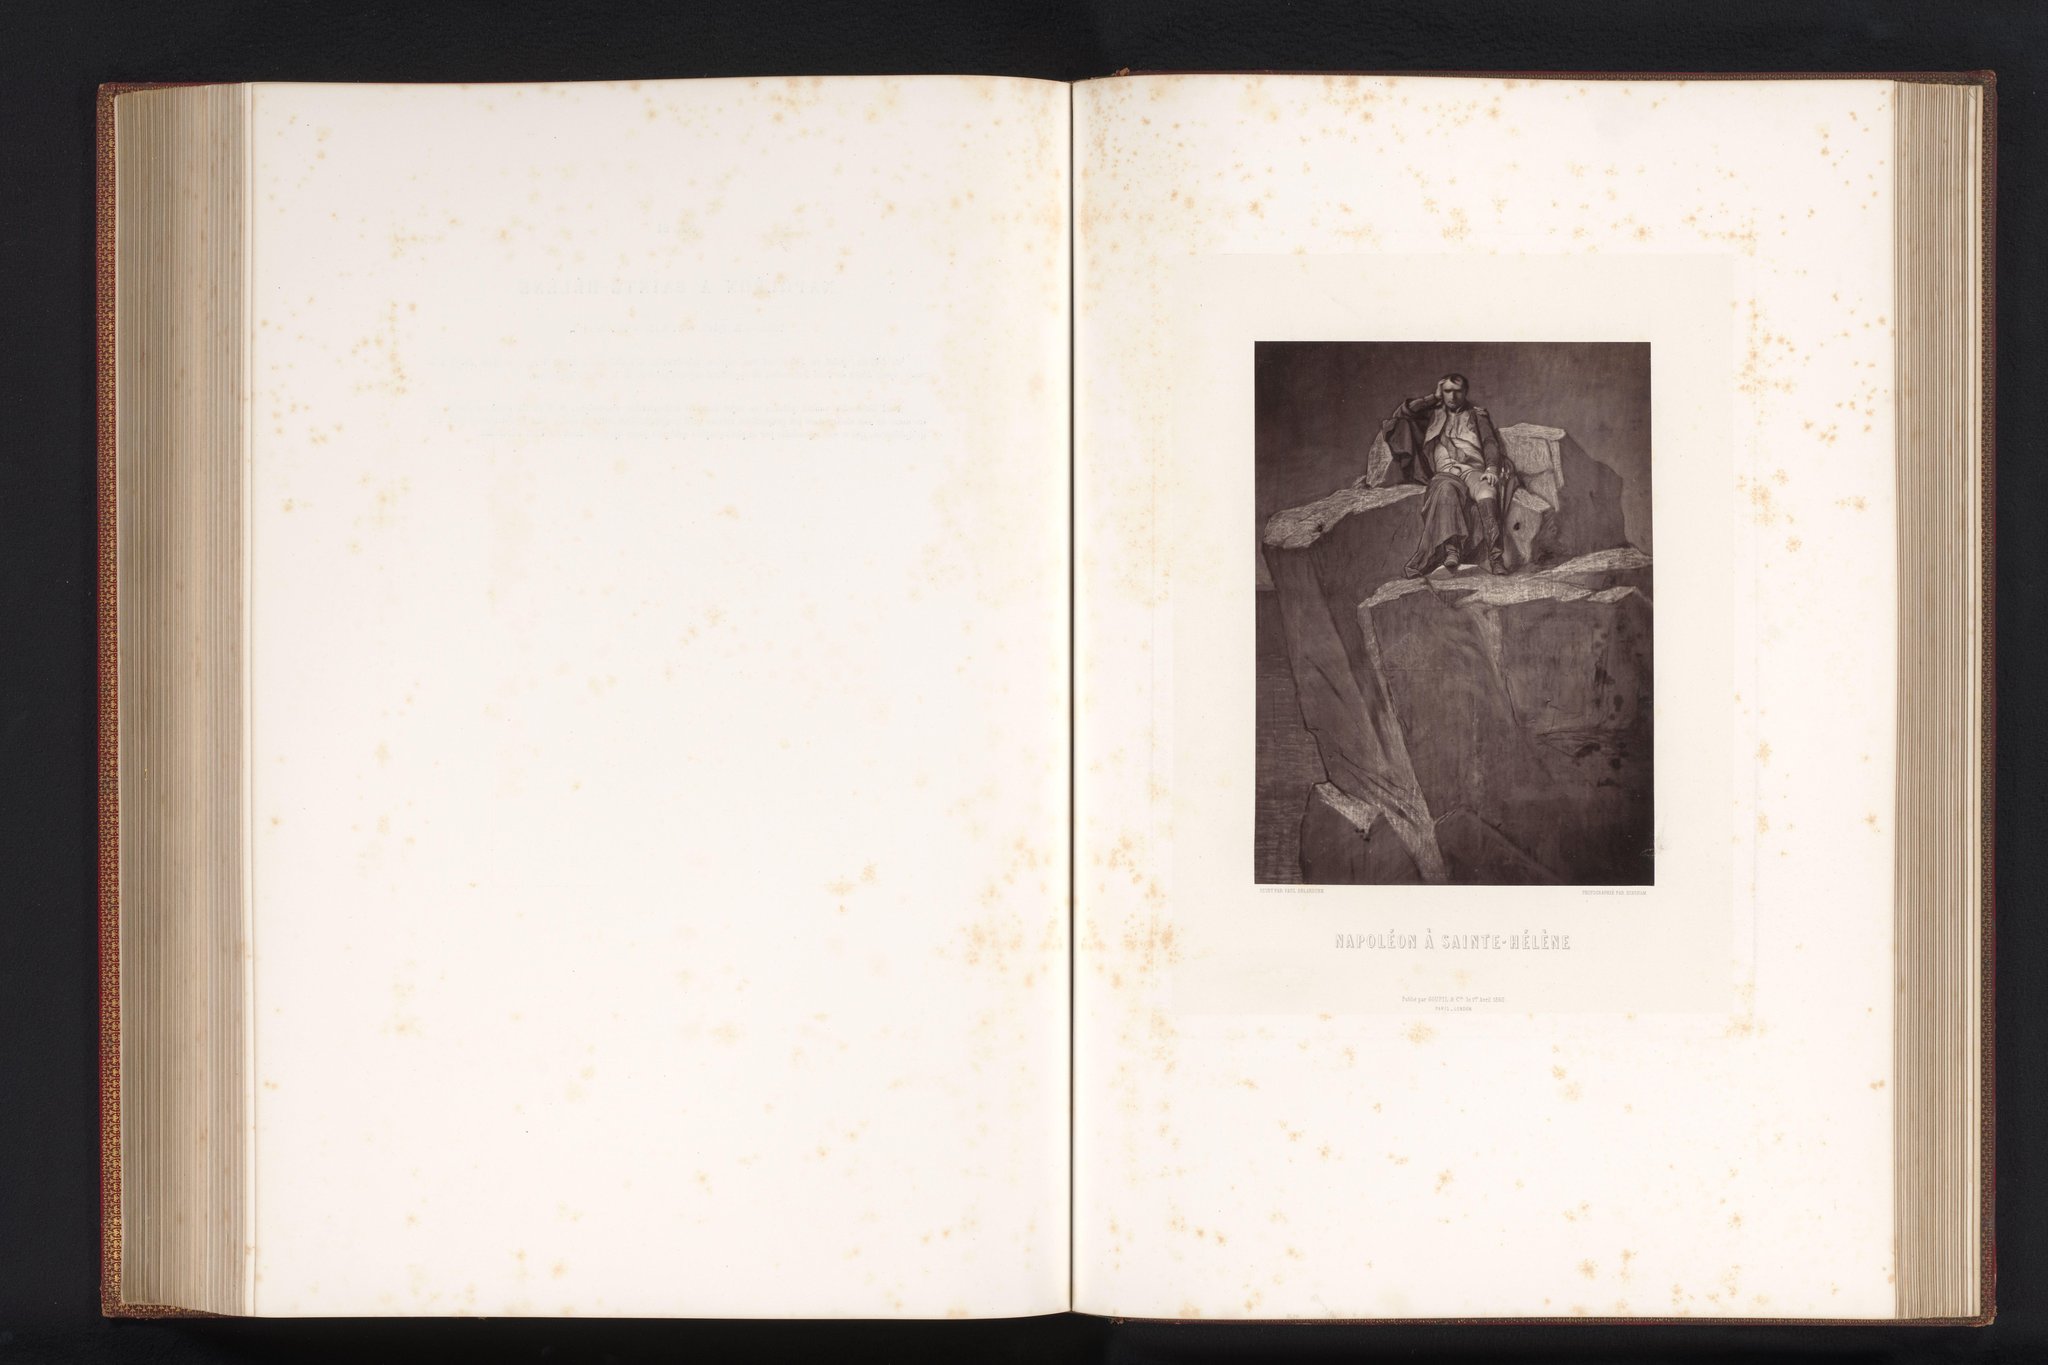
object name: page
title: Napoléon à Sainte-Hélène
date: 1853-1858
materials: paper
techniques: albumen print, engraving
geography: paris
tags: napoleon i (emperor of the french), loneliness; 'solitudine' (ripa), historical persons, rock-formations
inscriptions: check stamp: ‘Goupil & Cie’